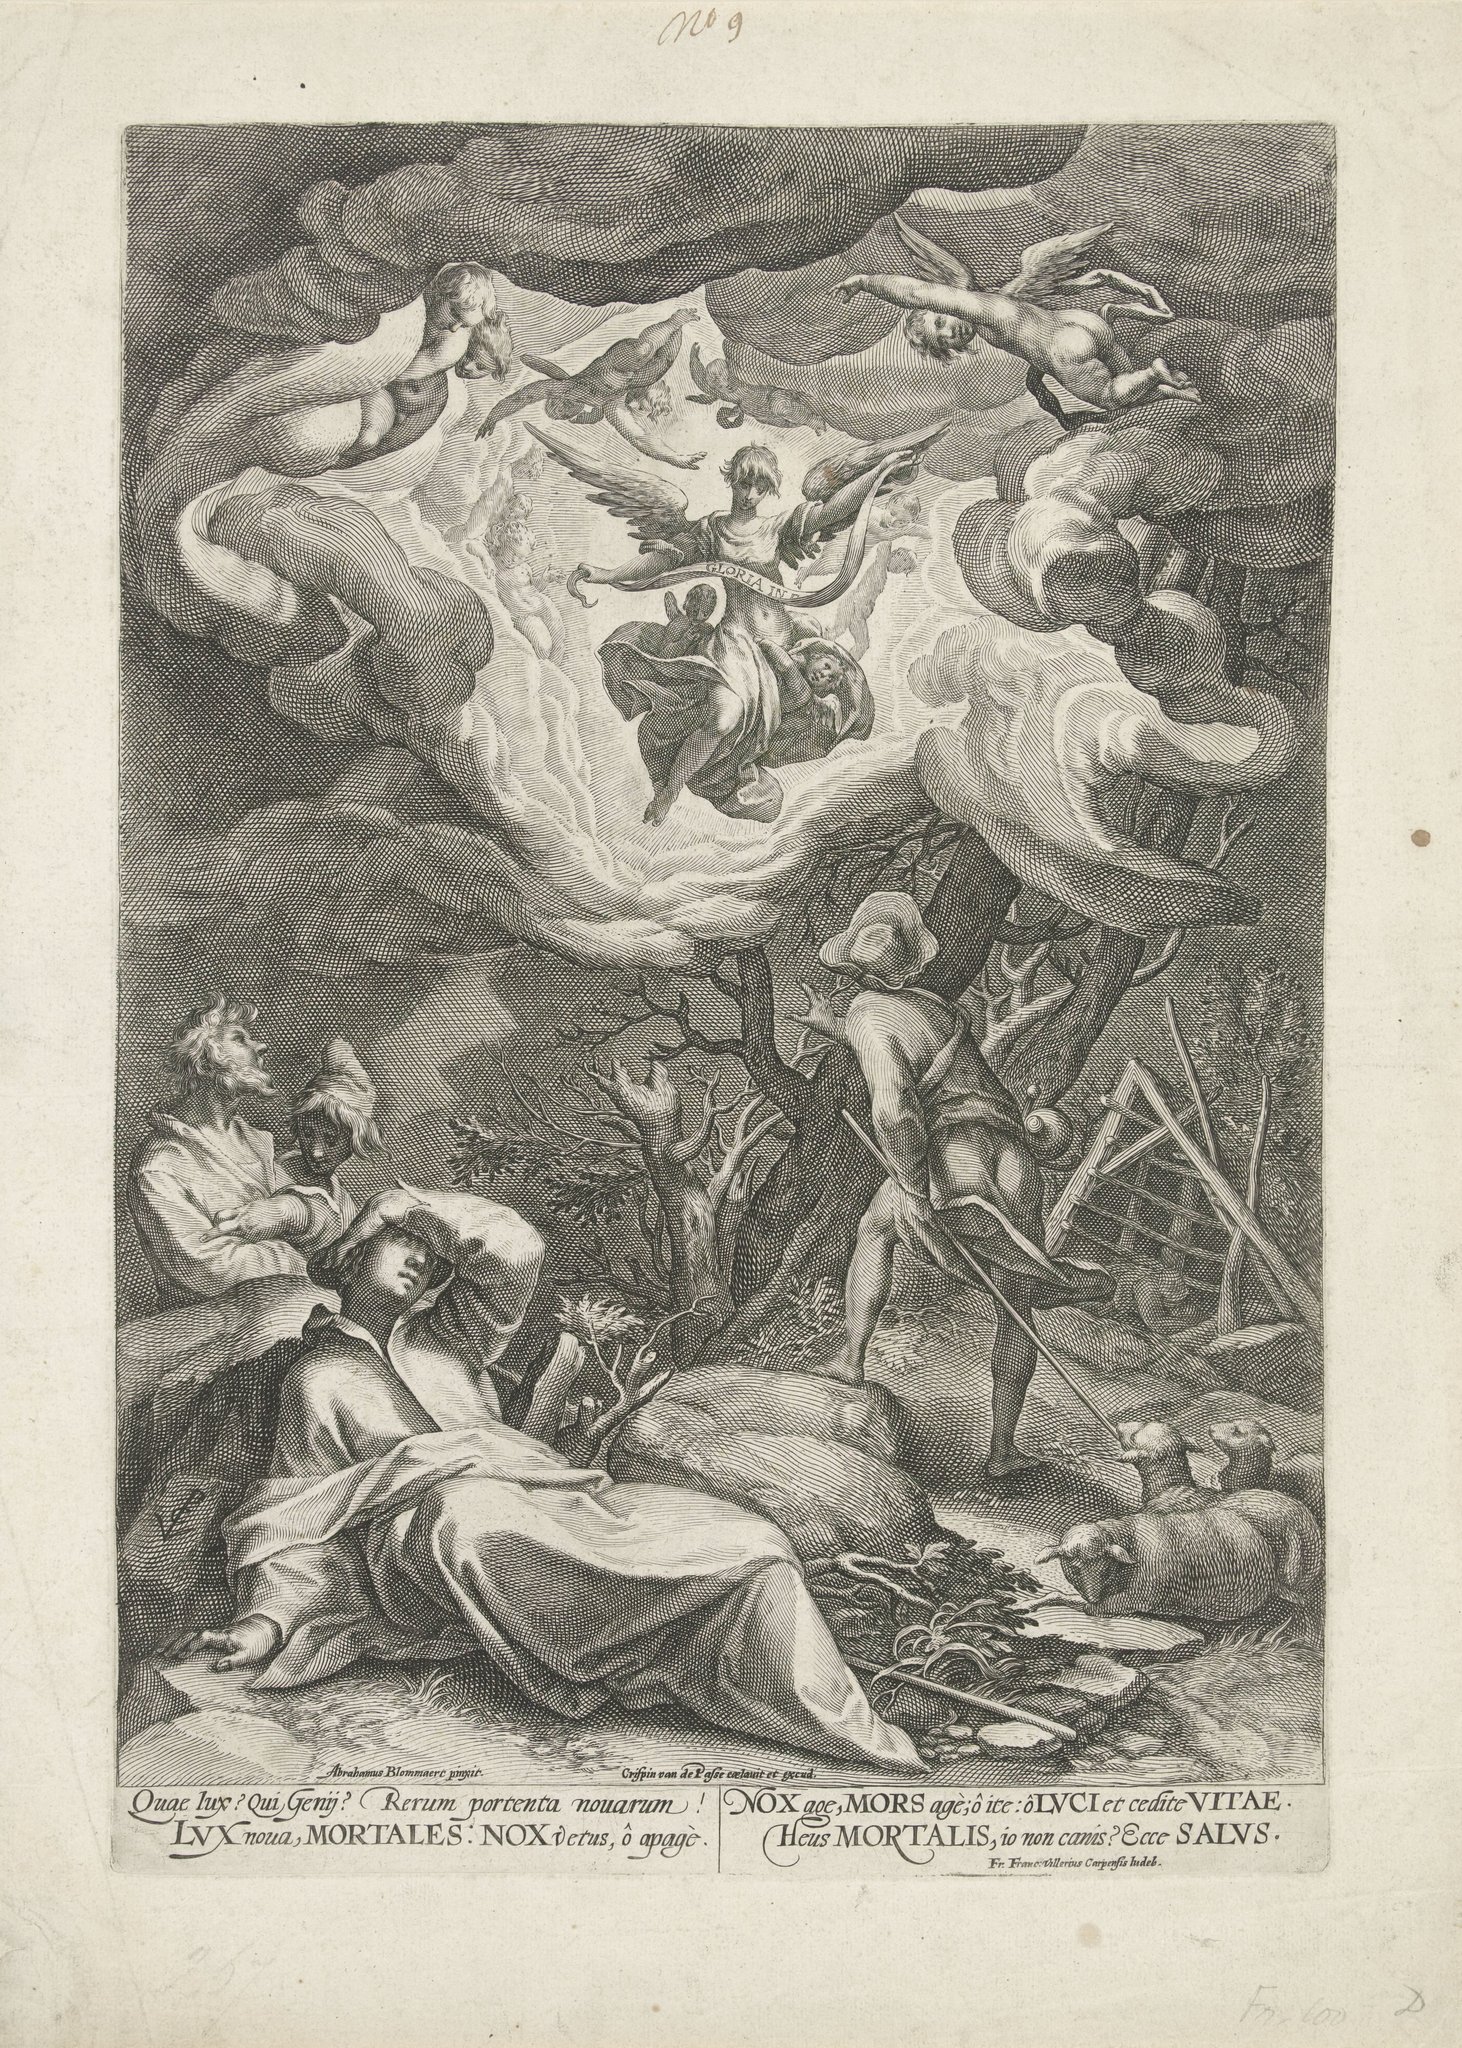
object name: print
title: Verkondiging aan de herders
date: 1574-1637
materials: paper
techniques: engraving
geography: utrecht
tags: annunciation of christ's birth to the shepherds (and/or shepherdesses) at night; a host of singing angels in the air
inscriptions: inscription: ‘nog’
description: De aankondiging van de geboorte van Christus aan de herders door de engel Gabriël. De herders kijken verschrikt naar de nachtelijke hemel waar de engel Gabriël verschijnt met een banderol met een boodschap. In de marge een vierregelig onderschrift, in twee kolommen, in het Latijn.